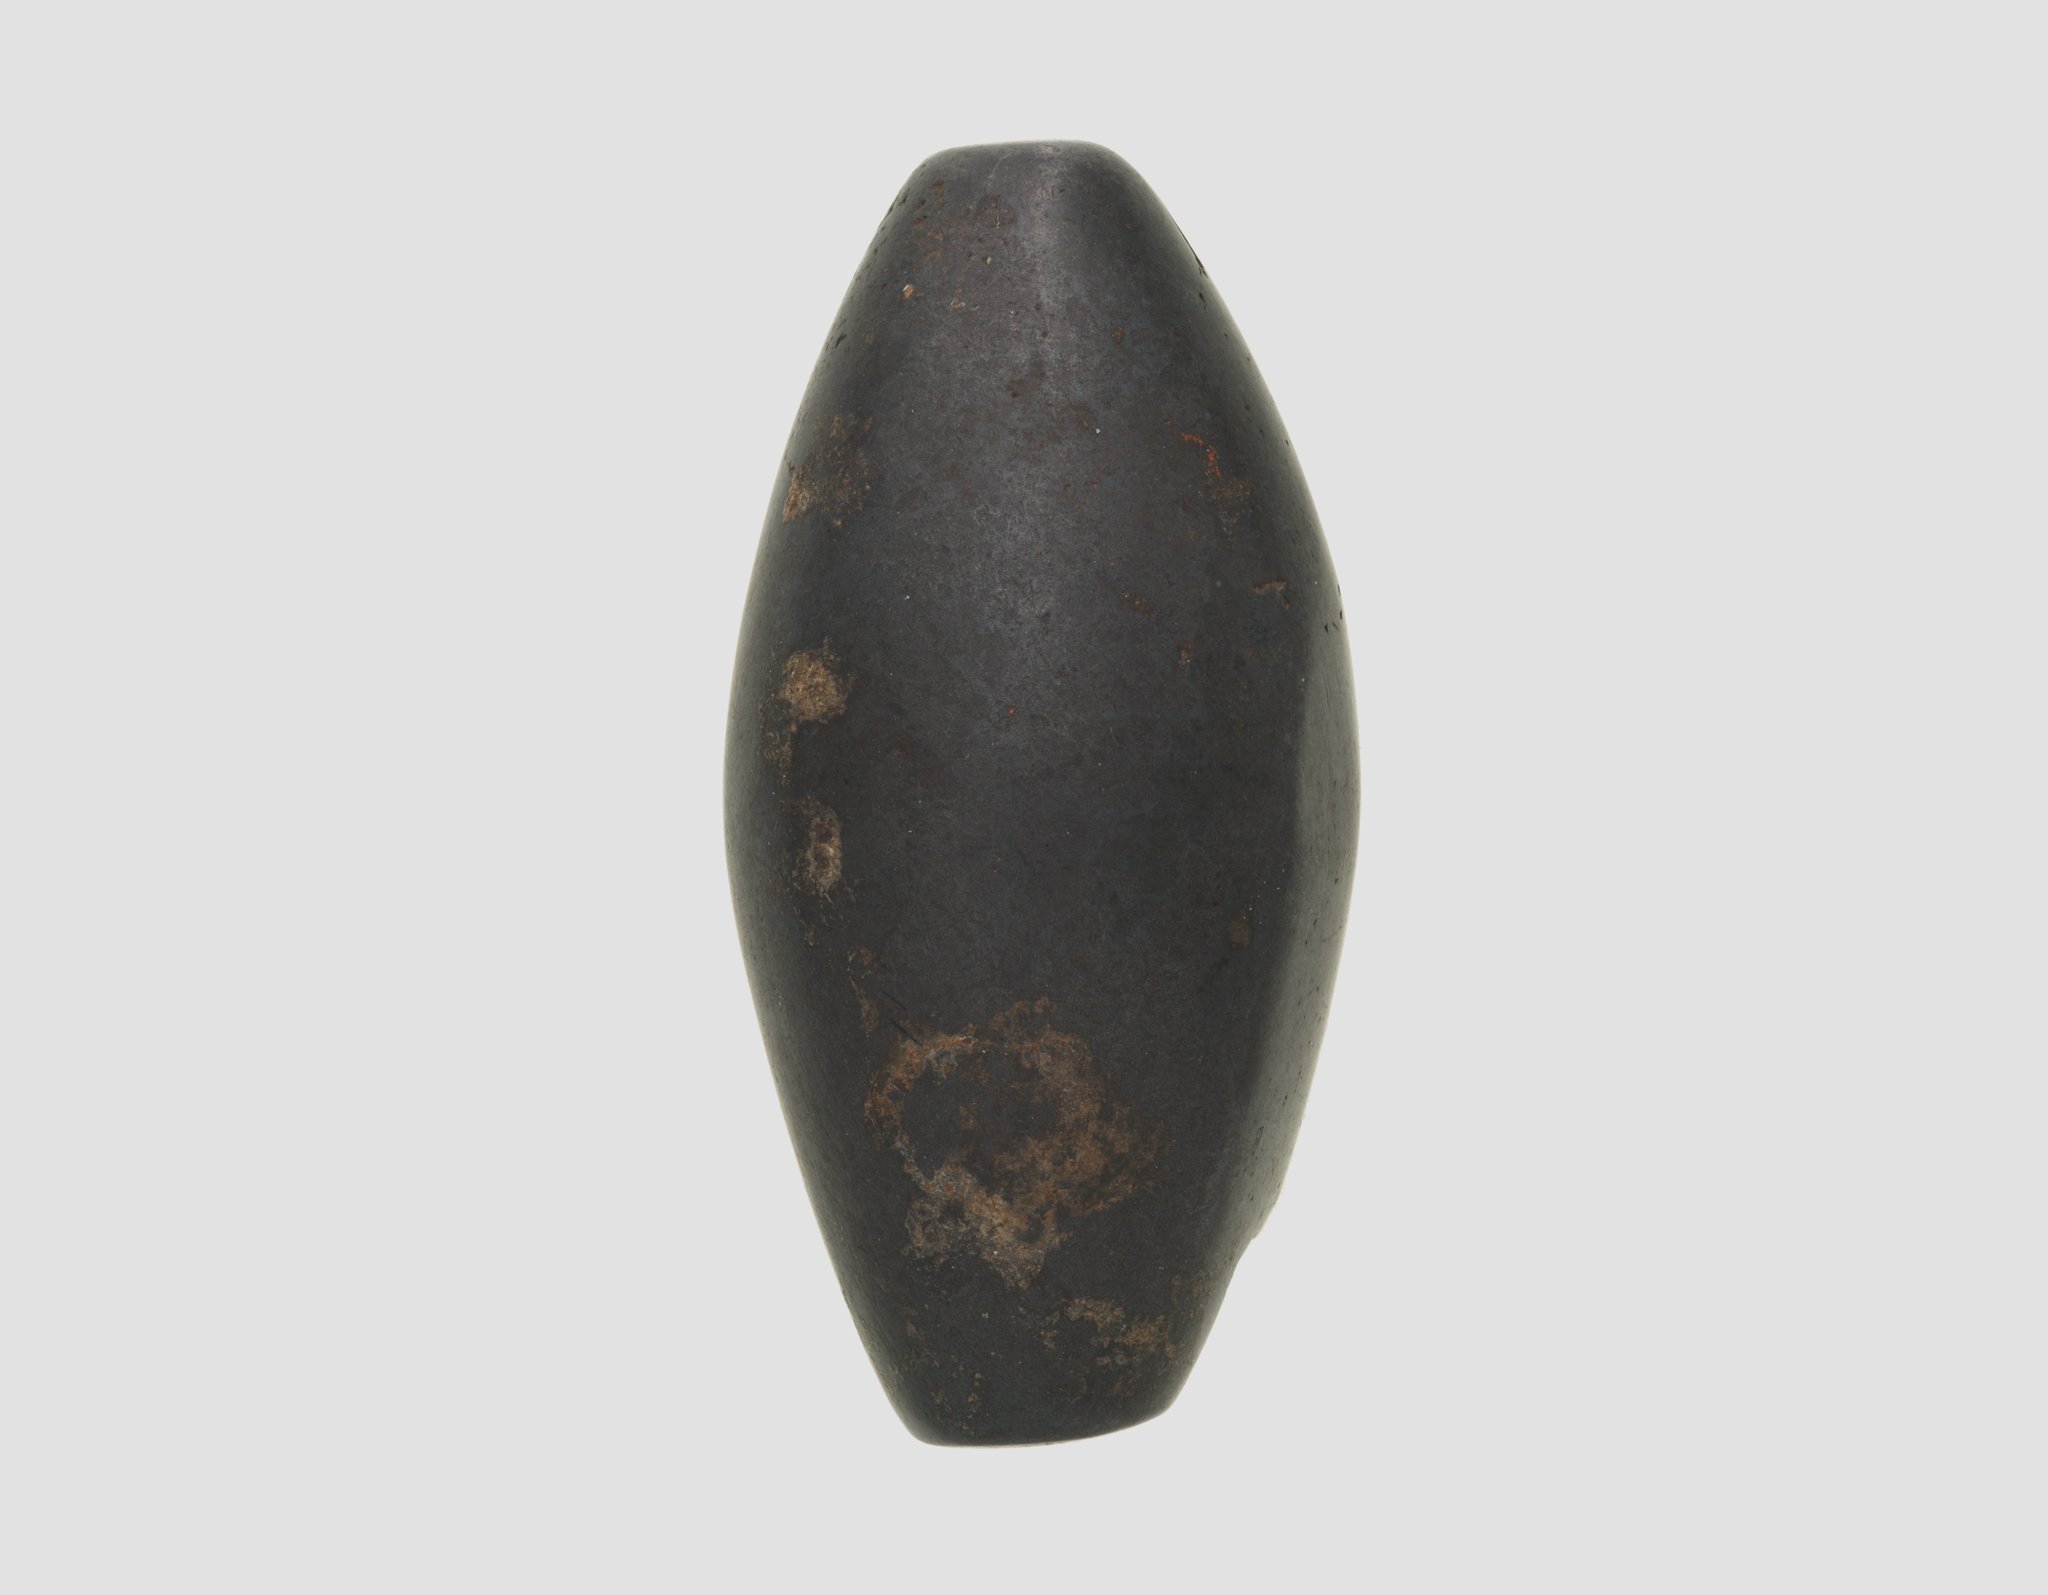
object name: weight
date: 3000-1 BCE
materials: mineral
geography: cyprus or western asia